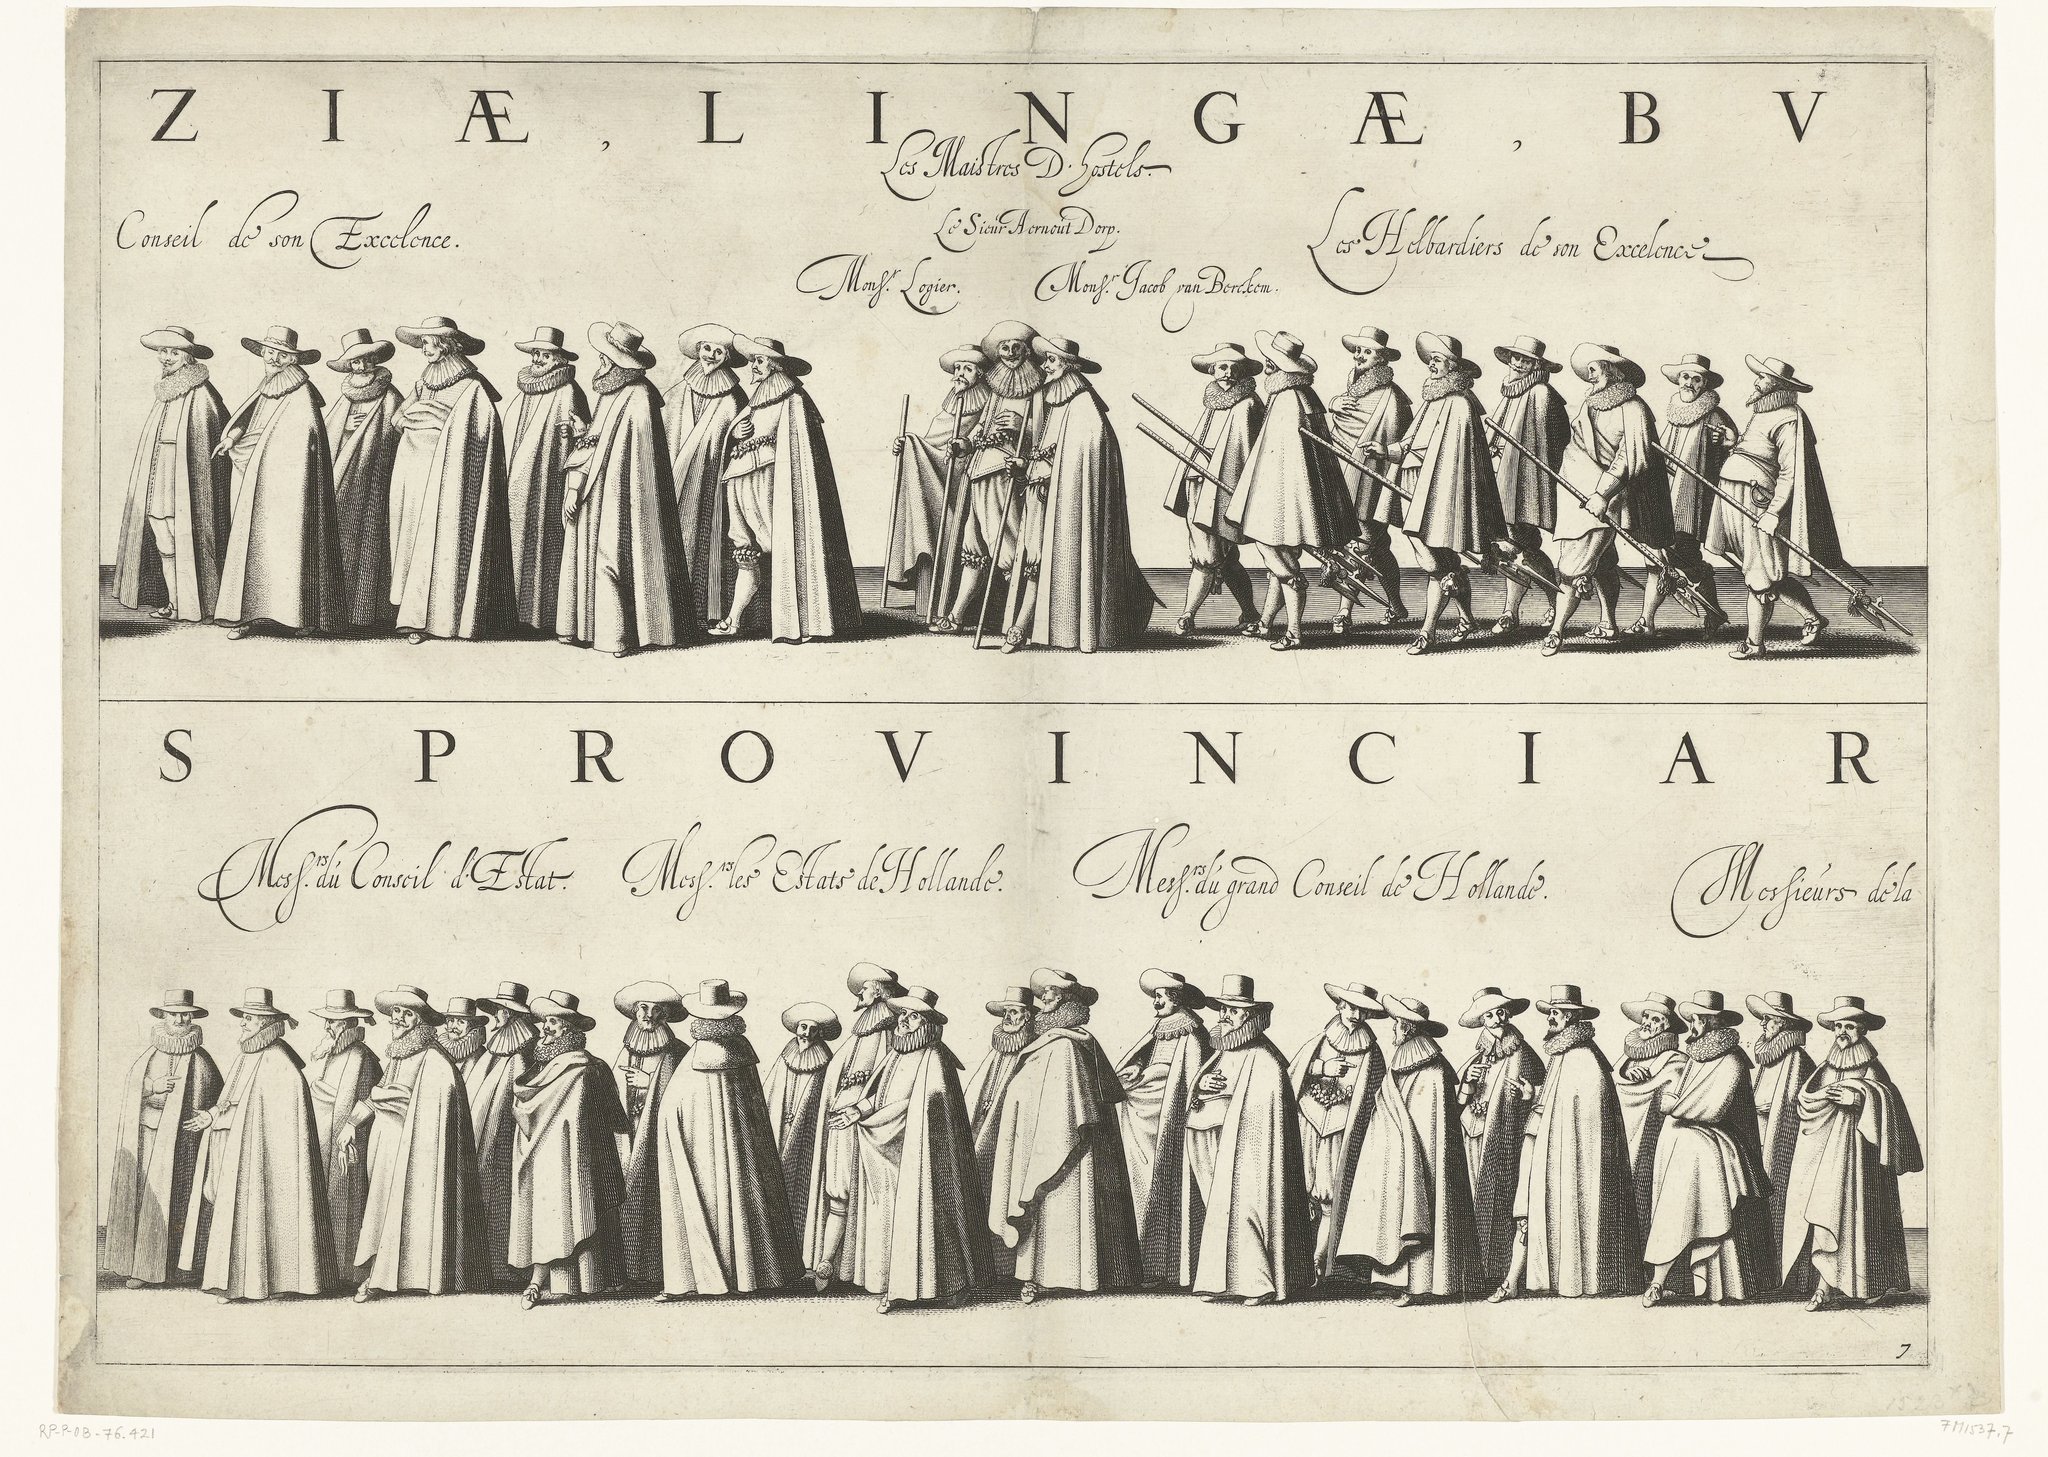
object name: print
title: De begrafenisstoet van prins Maurits te Delft, 1625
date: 1626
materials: paper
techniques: etching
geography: amsterdam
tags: the hague, maurice (prince of orange), cortege, funeral procession, delft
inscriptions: date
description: De begrafenisstoet van prins Maurits te Delft op 16 september 1625 (plaat 7). Plaat verdeeld in twee voorstellingen. Boven: deel van de stoet met deelnemers. Onder: deel van de stoet met deelnemers. Met de namen van de afgebeelde personen.